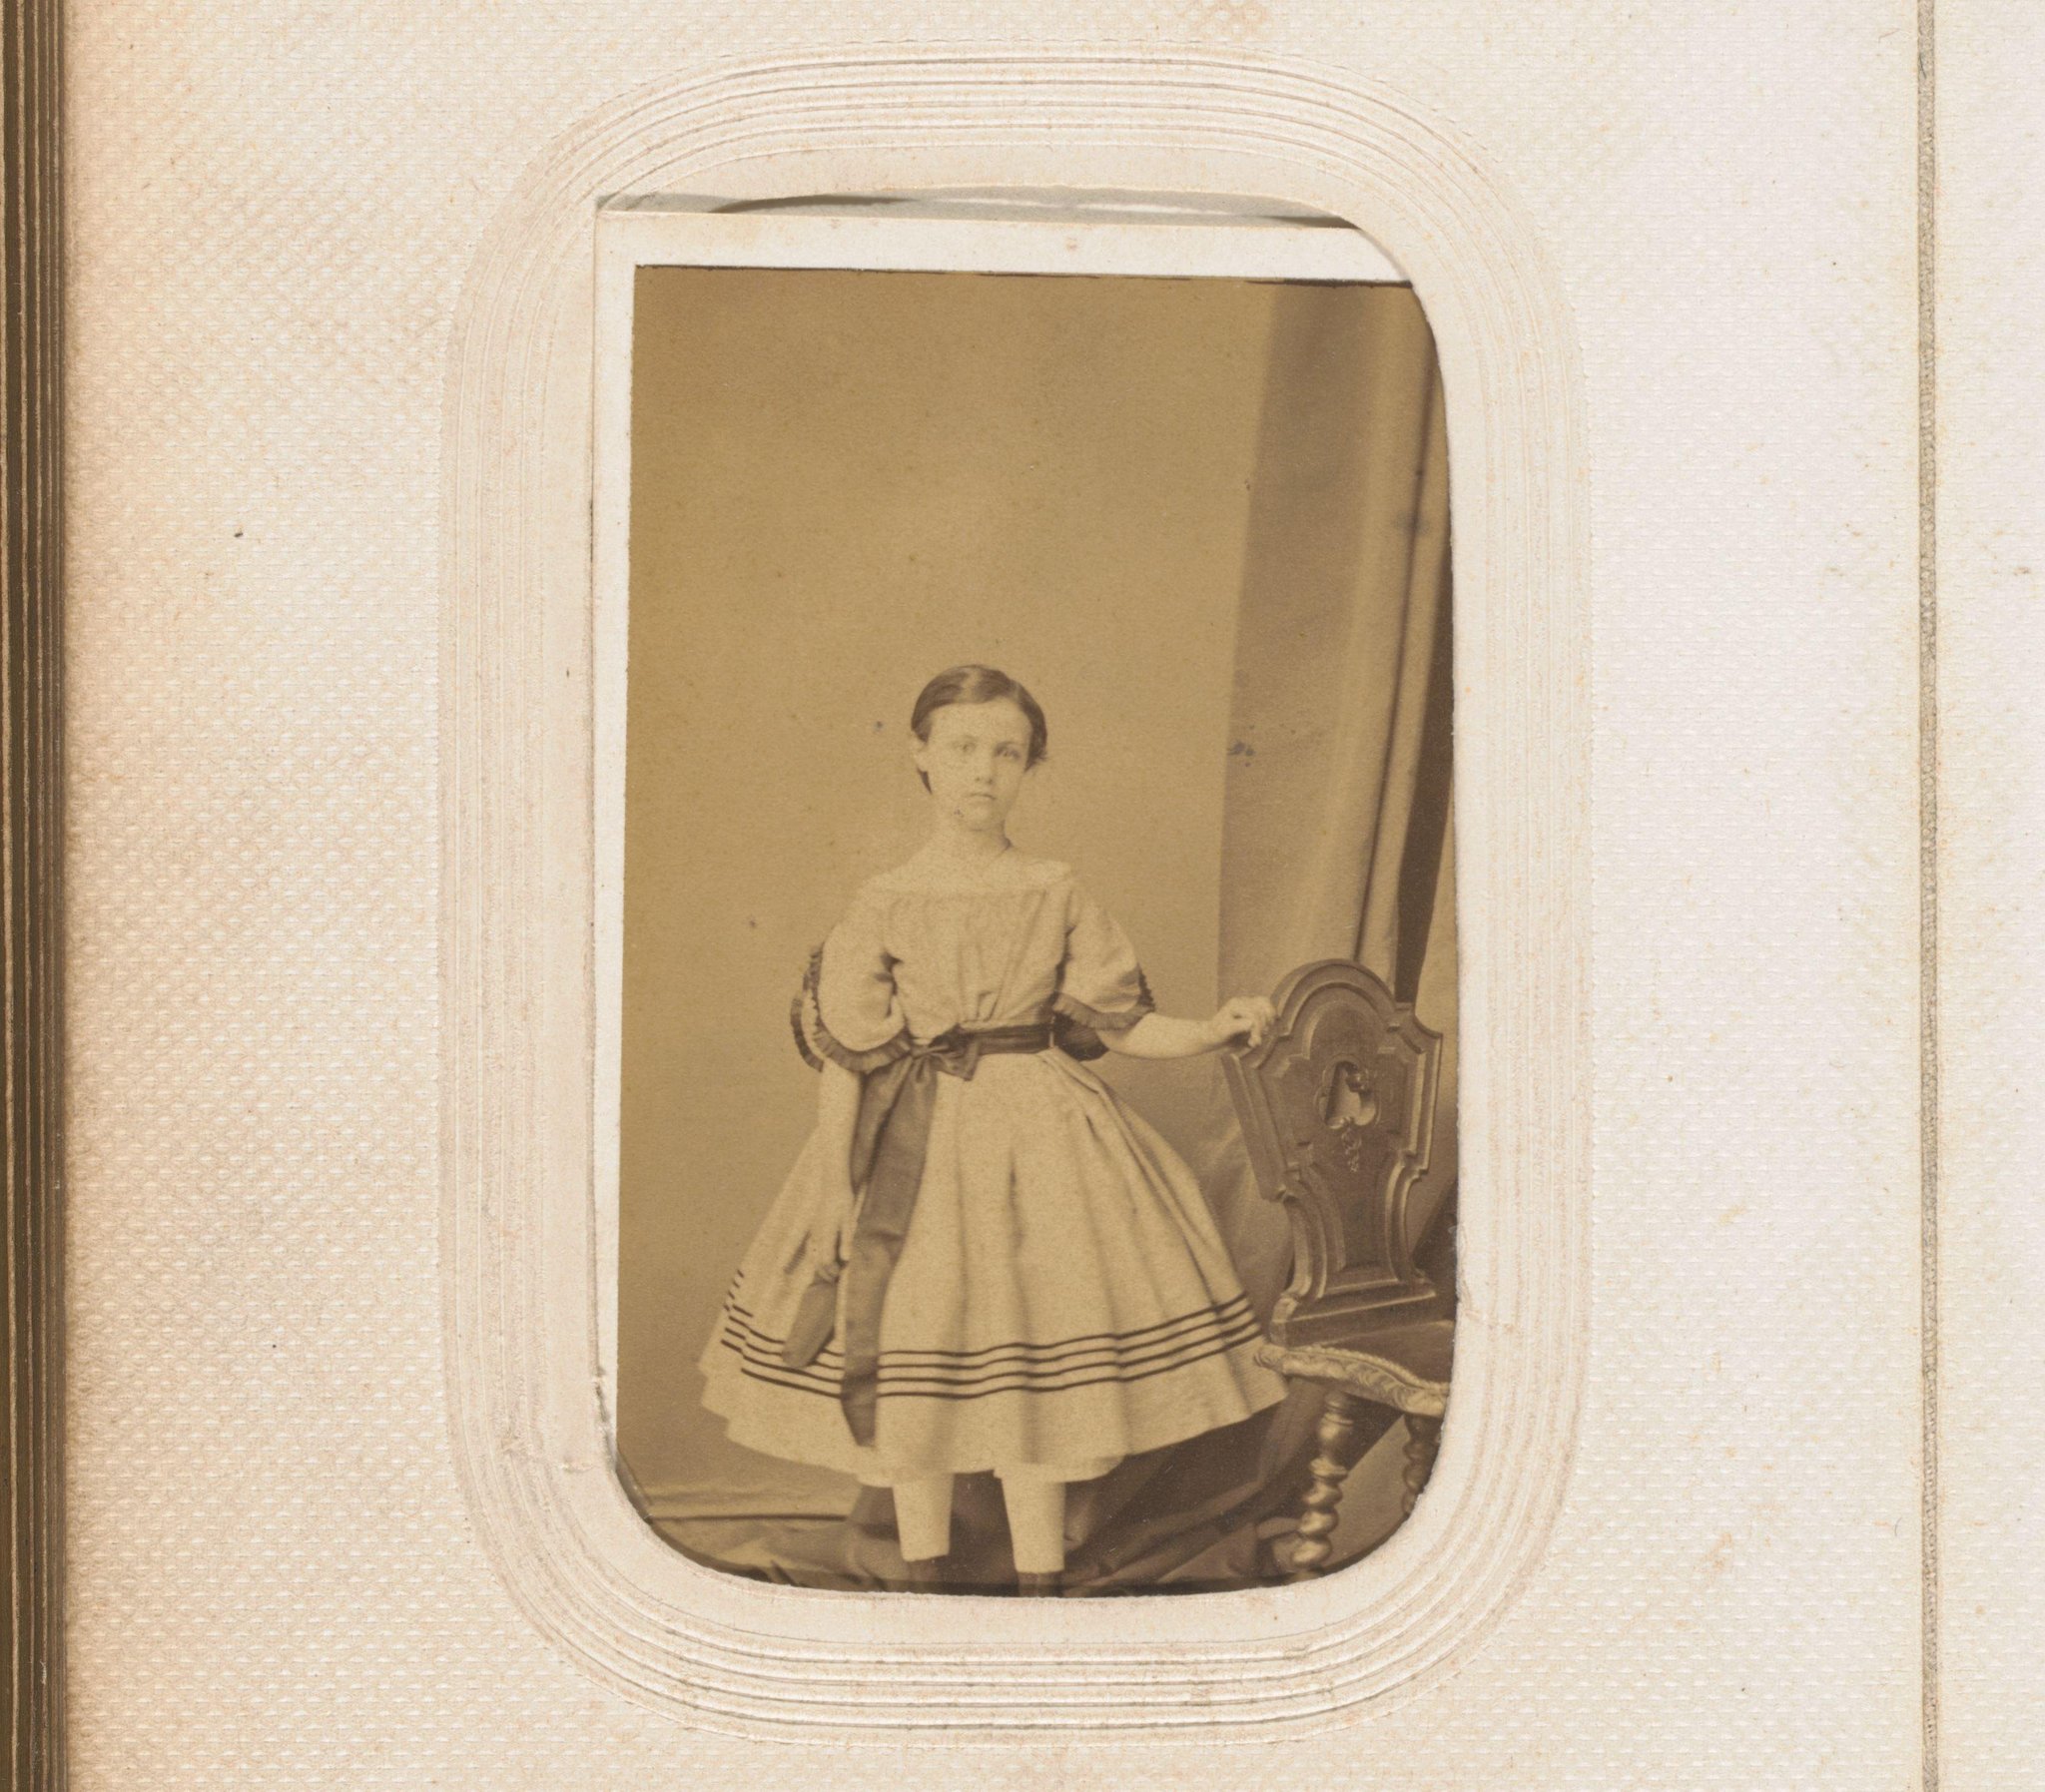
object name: photograph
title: Portret van een staand meisje bij een stoel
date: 1855-1865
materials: cardboard, photographic support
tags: historical persons, chair, child between toddler and youth (of undetermined sex)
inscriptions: inscription: ‘3 Rue Mautrec, Bordeaux’